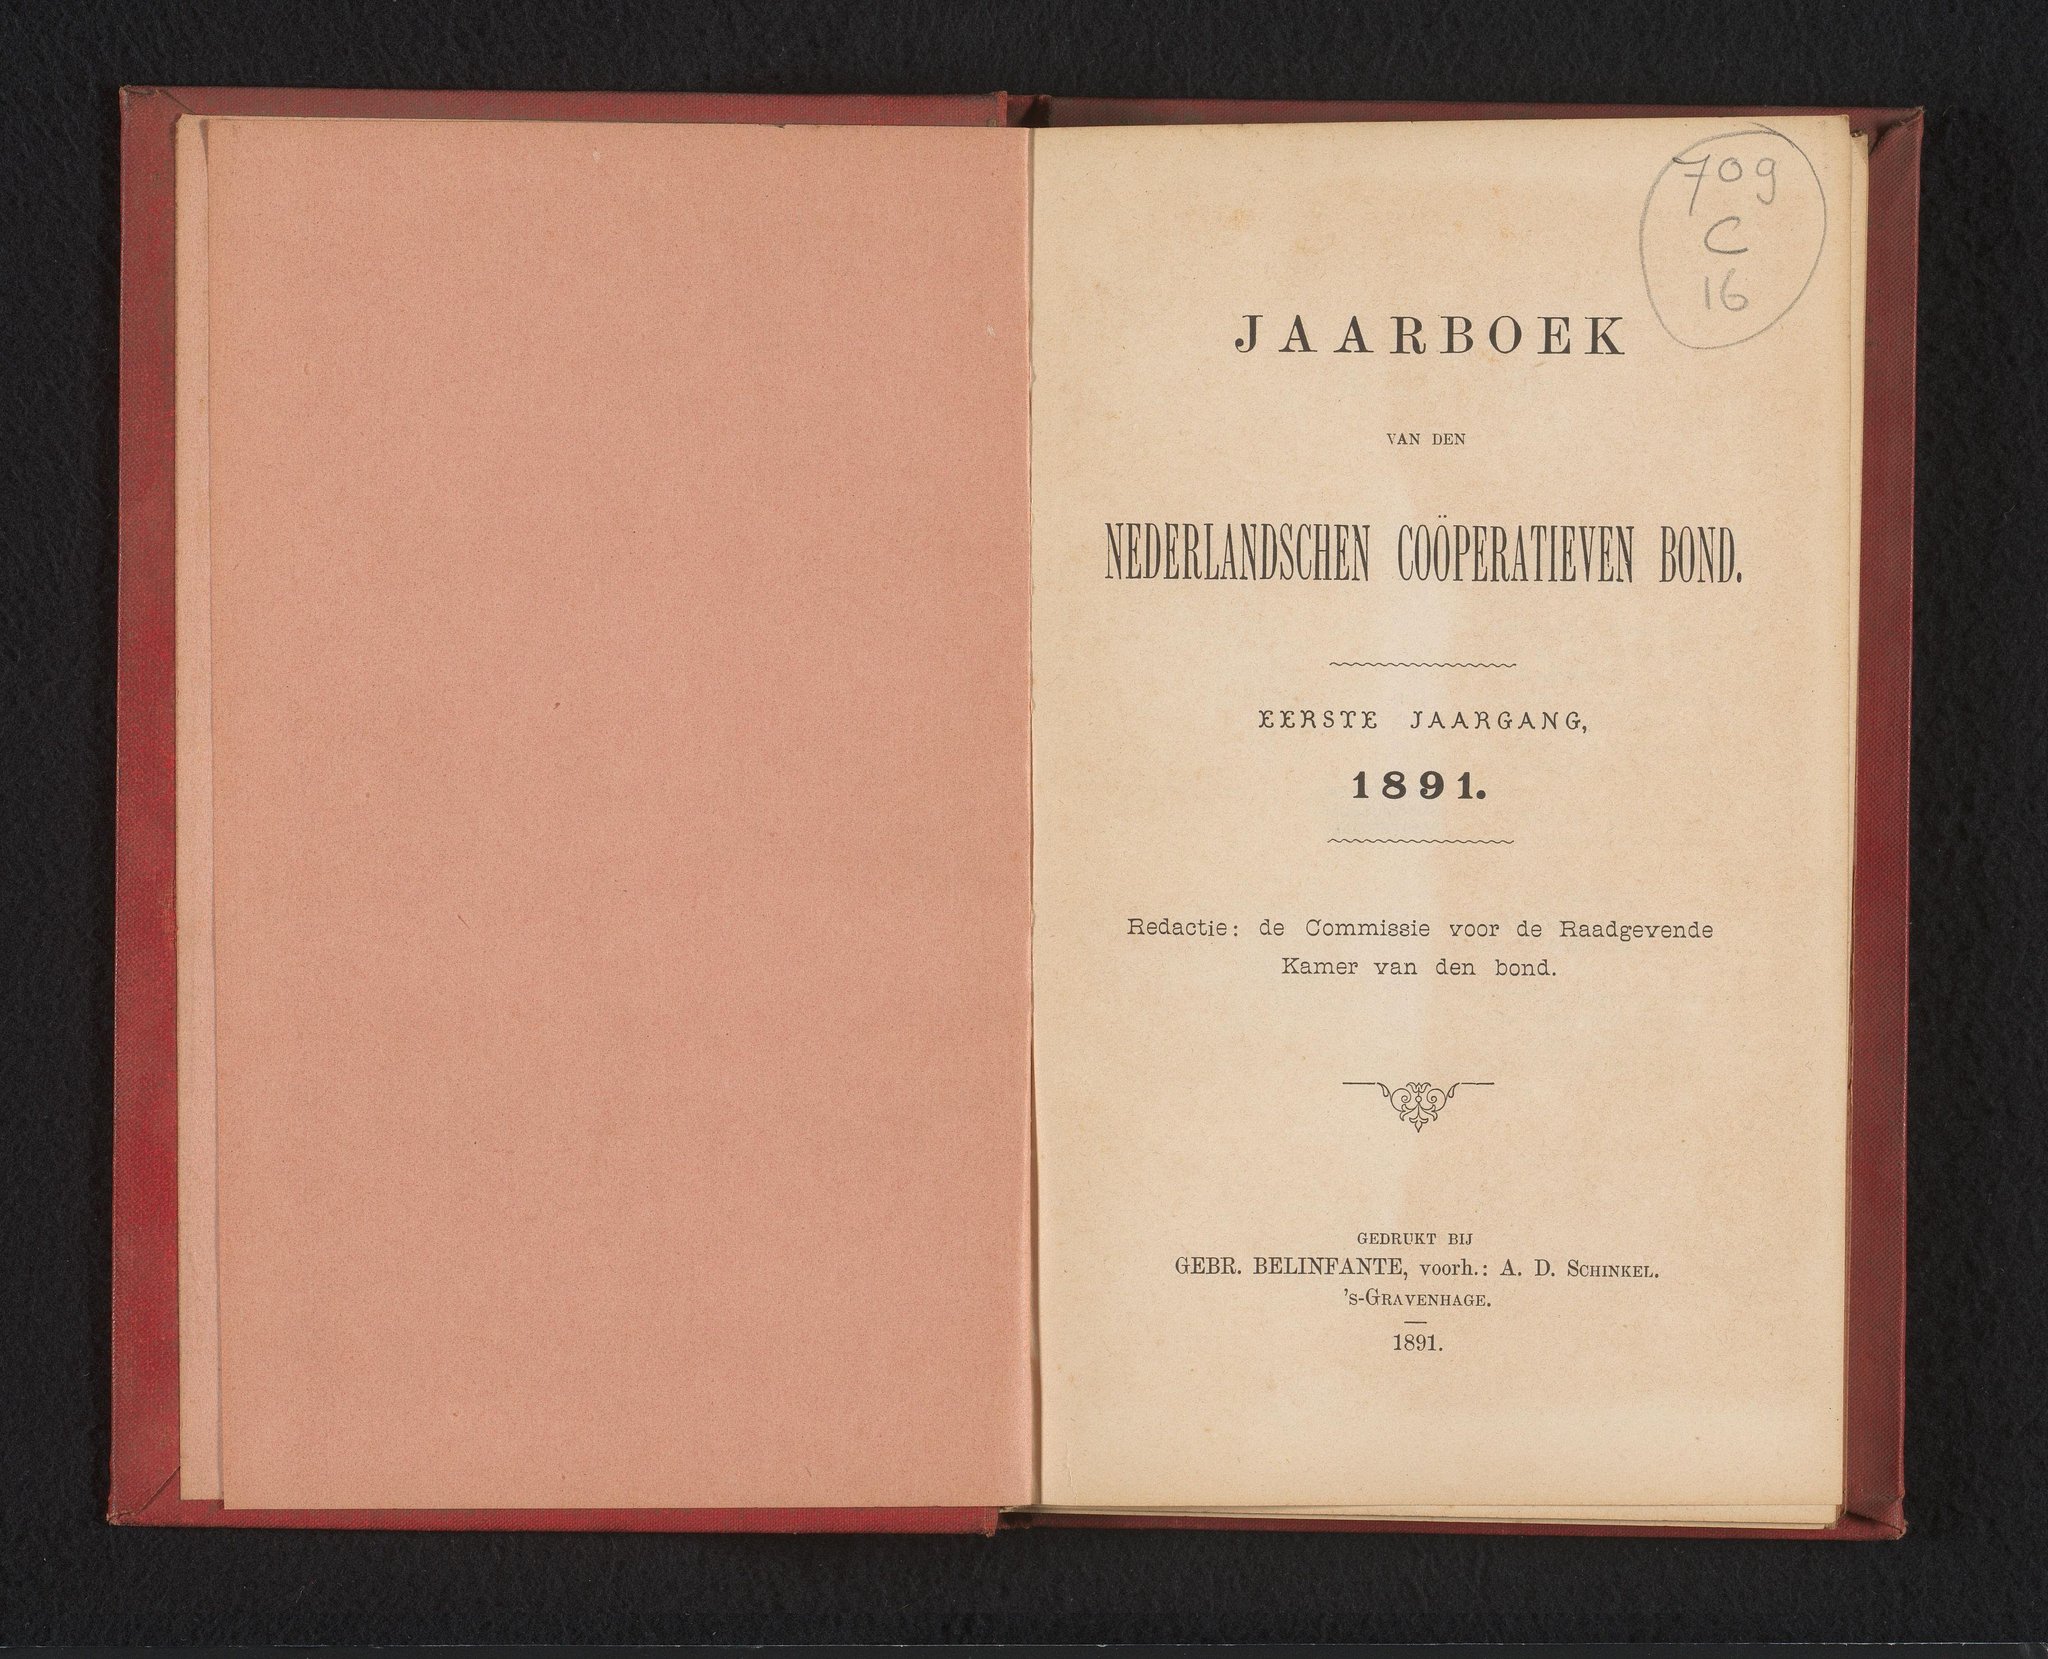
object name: book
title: Jaarboek van den Nederlandschen Coöperatieven Bond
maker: jacob kuyper (1821-1908)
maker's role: cartograaf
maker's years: 1821-1908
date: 1891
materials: cardboard, paper, textile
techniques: printing, woodburytype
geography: the hague